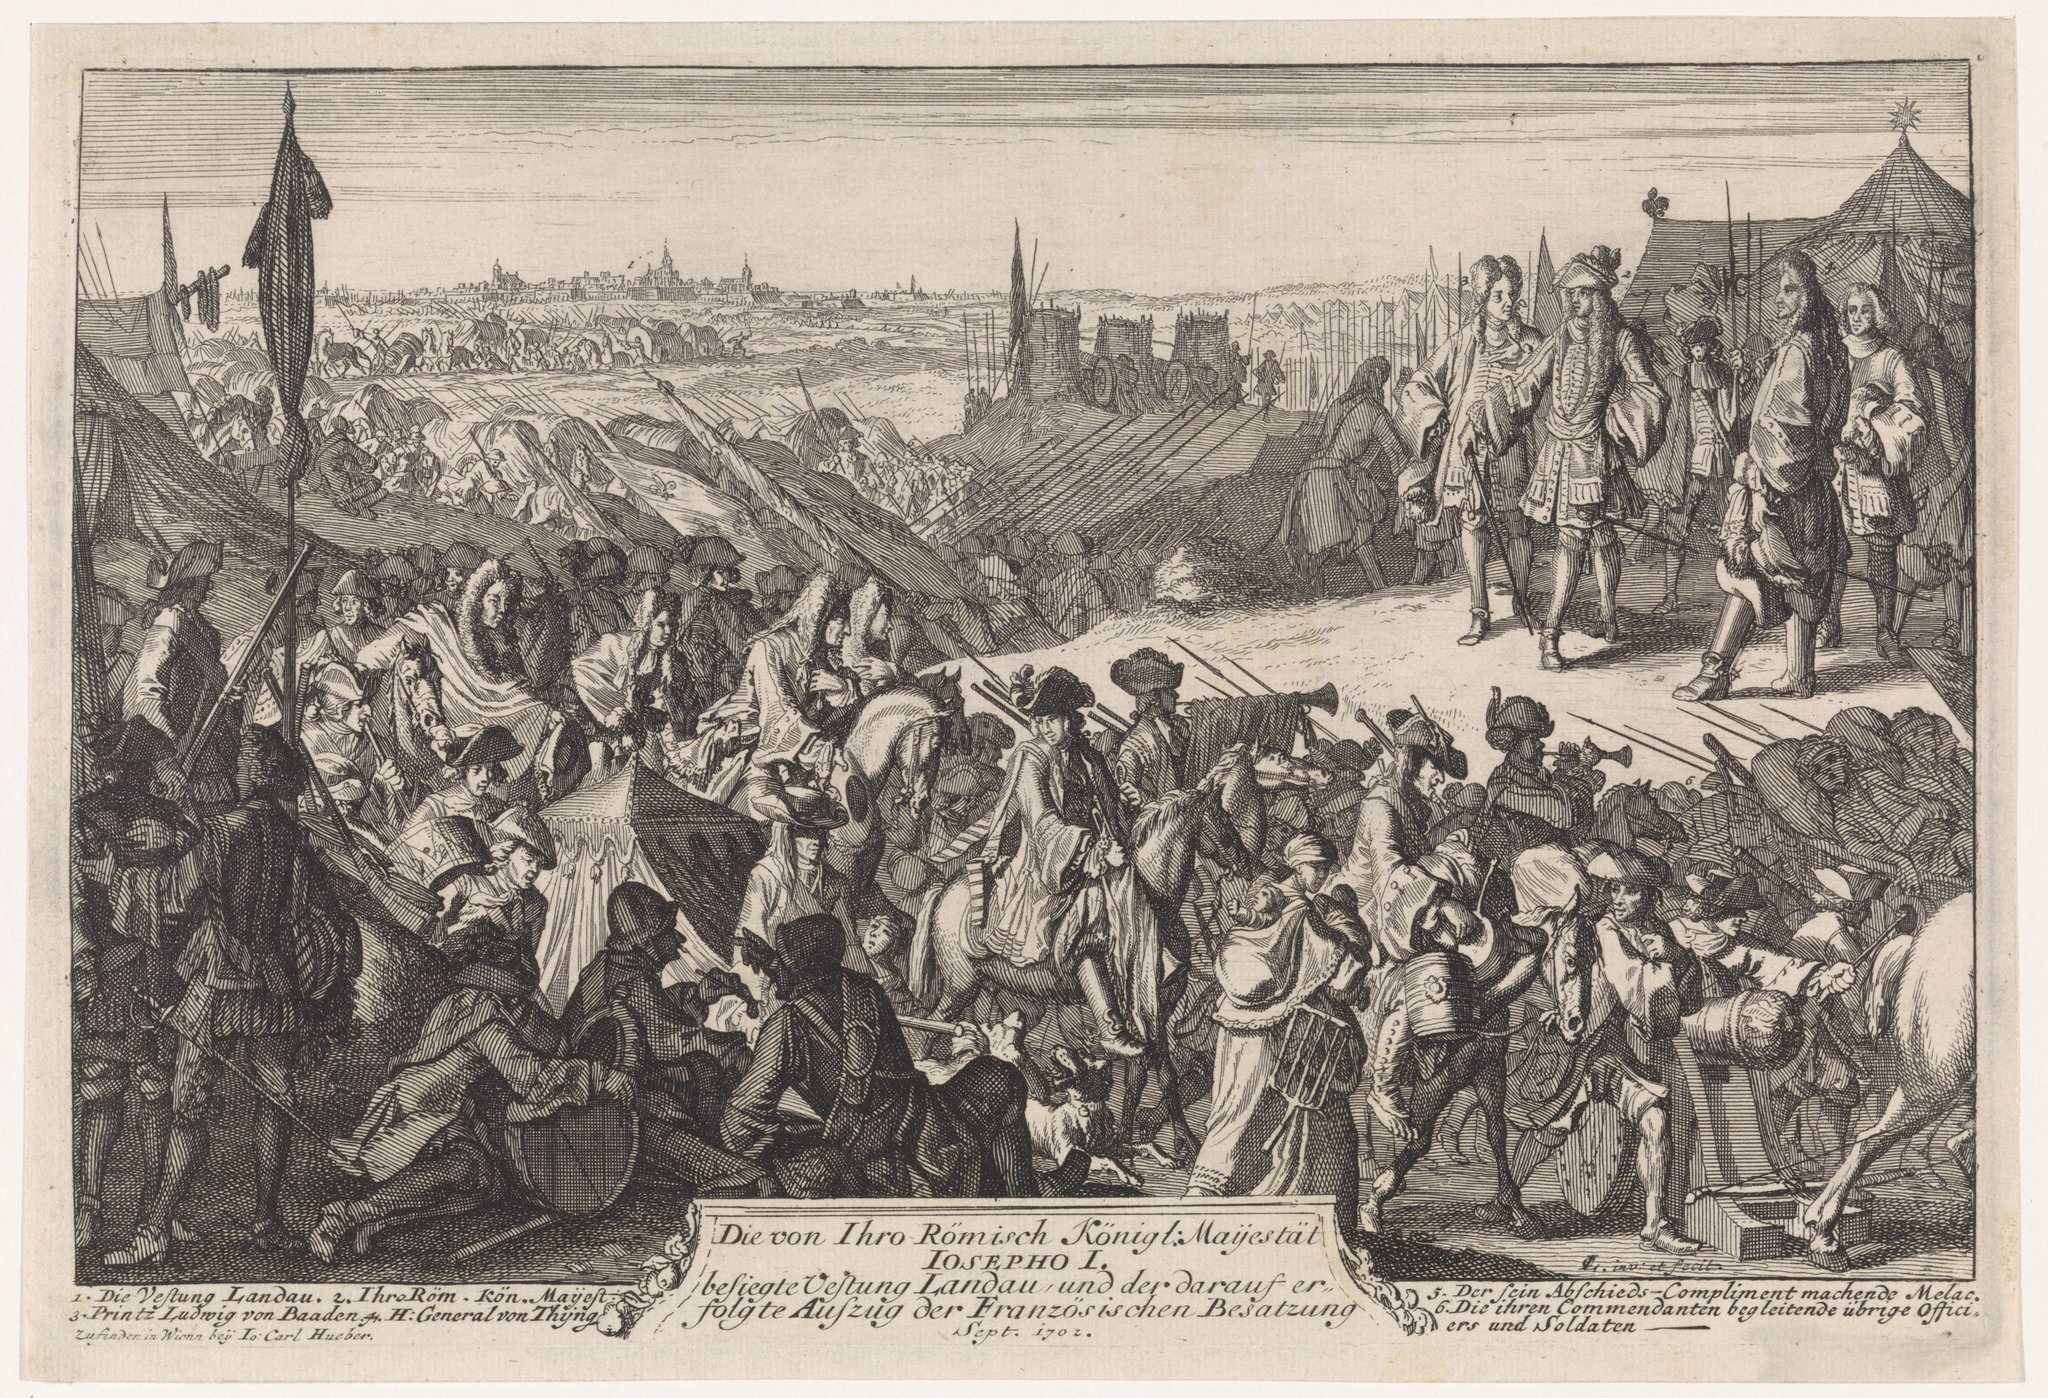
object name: print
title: Inname van Landau, 1702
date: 1702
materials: paper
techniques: etching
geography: vienna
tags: vienna, jozef i (duits keizer), paris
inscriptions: collector's mark: Lugt 2228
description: Het beleg van Landau, veroverd op de Fransen door keizerlijke troepen onder Lodewijk Willem I, markgraaf van Baden-Baden, 10 september 1702. Rechts staats Jozef I met prins Lodewijk Willem. Op de achtergrond vertrekken de Franse troepen uit Landau. De prent heeft een Duits onderschrift met aanwijzingen.